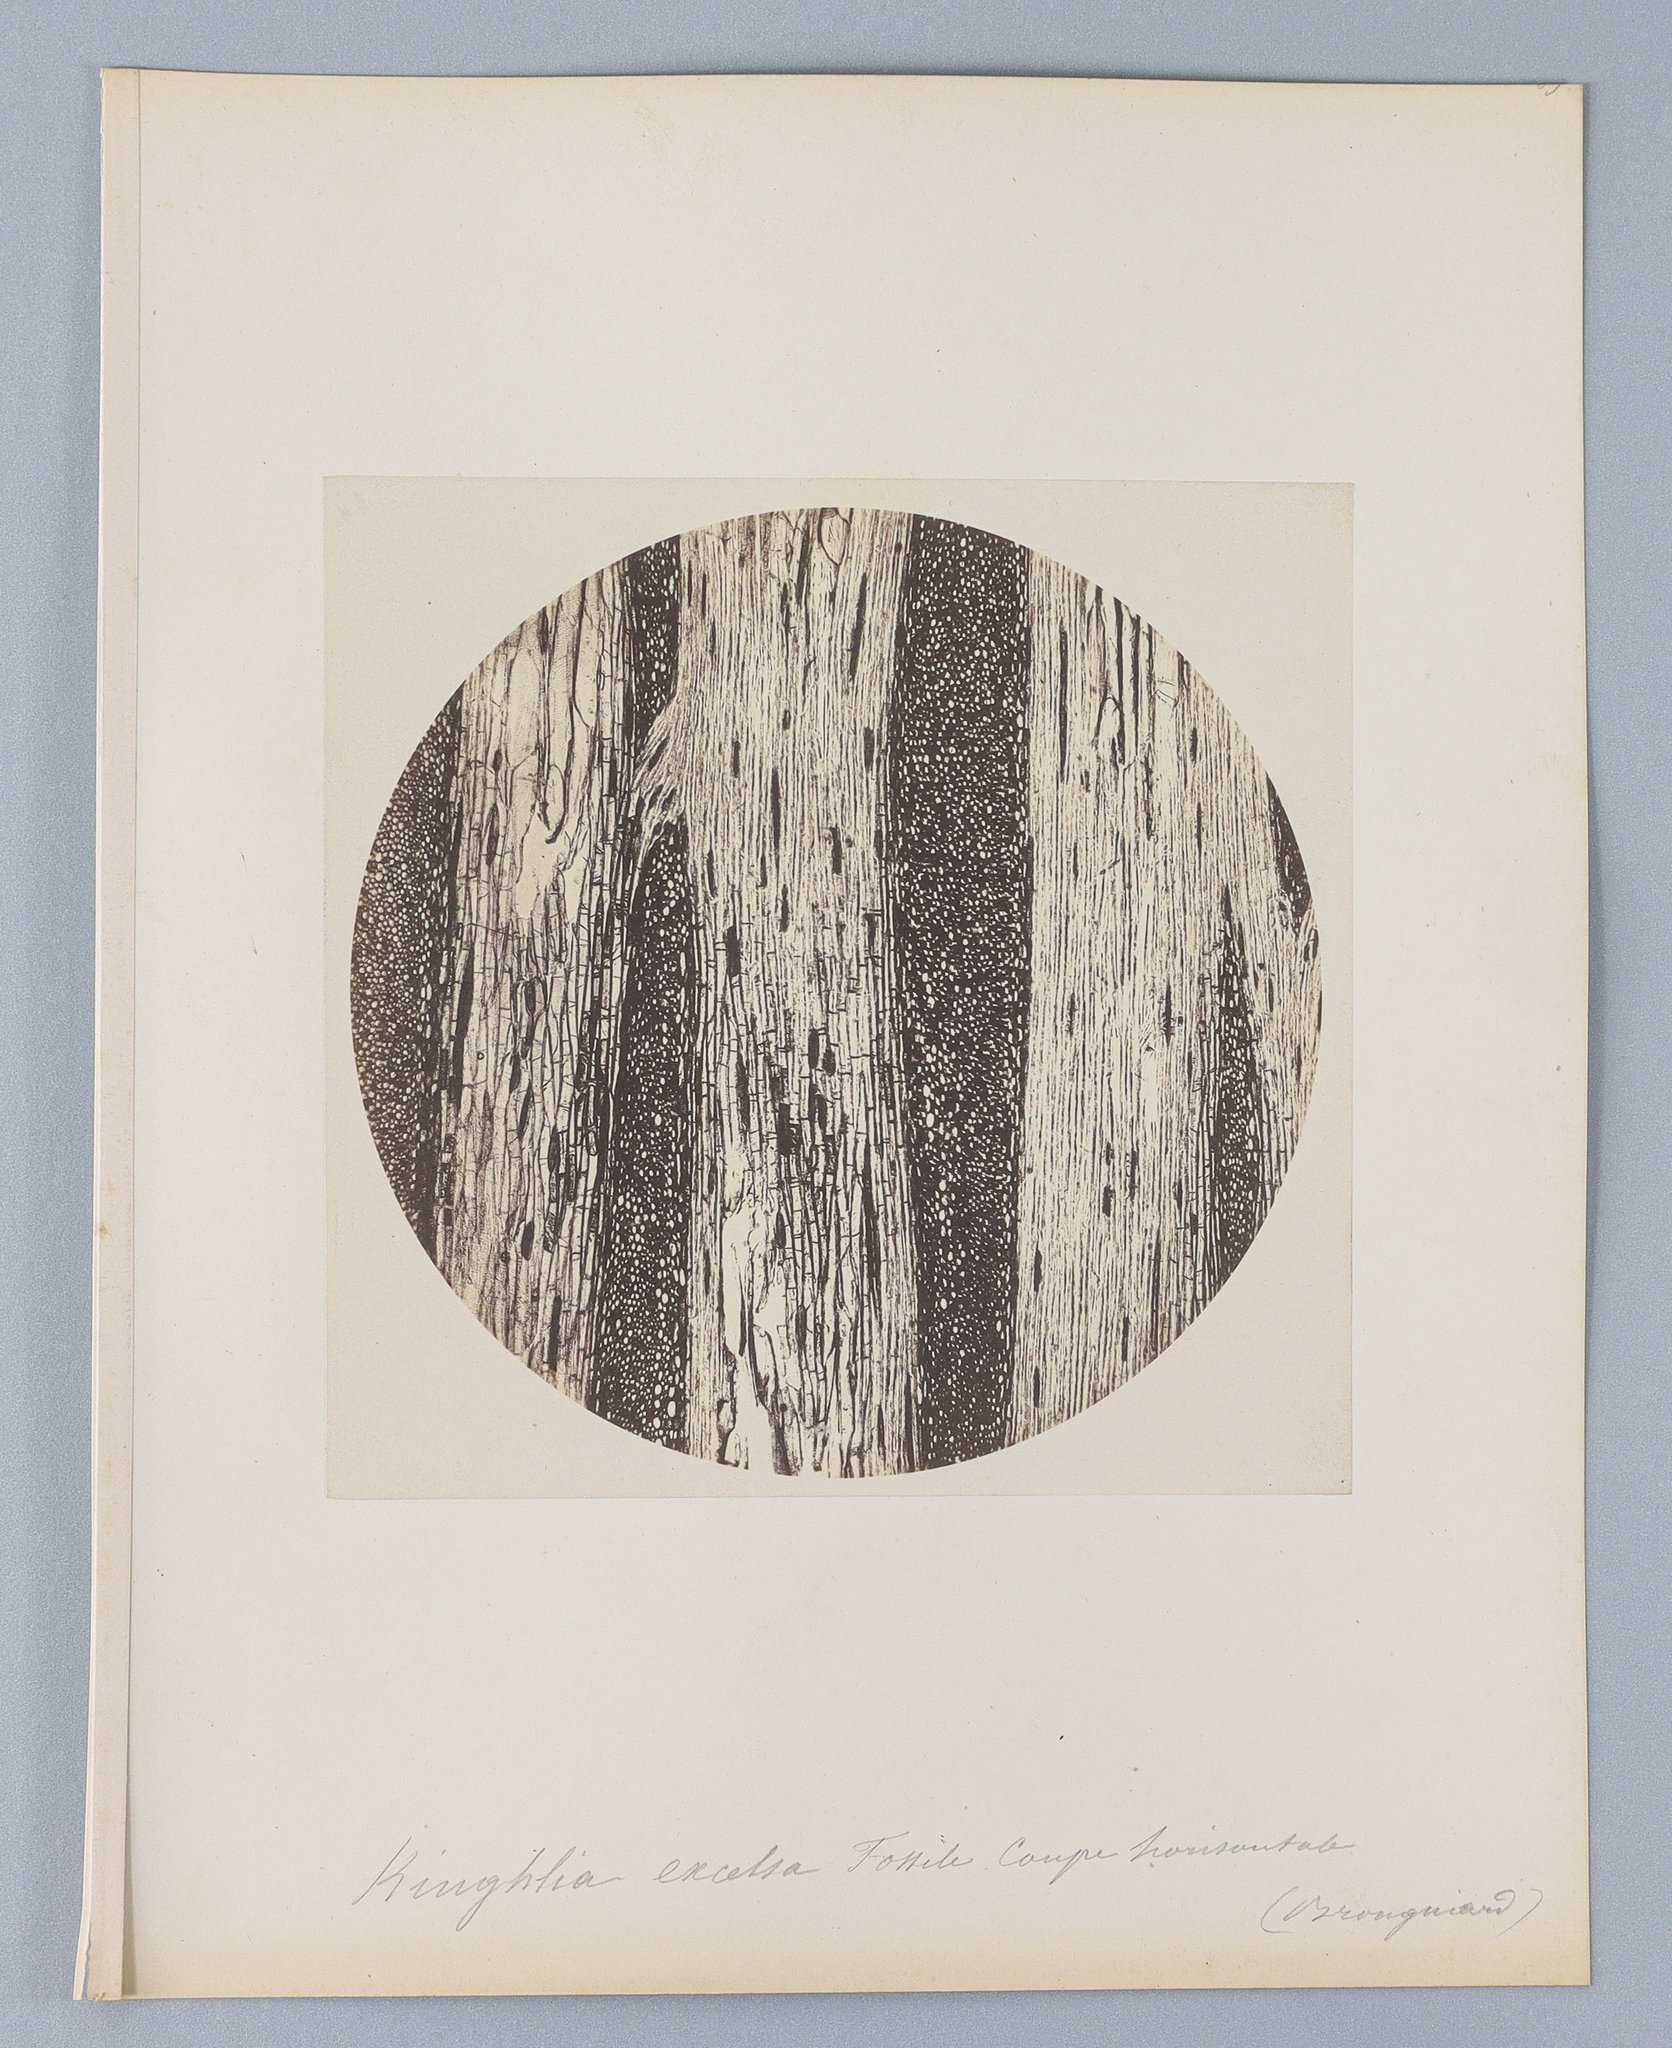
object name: photograph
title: [Untitled]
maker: auguste-adolphe bertsch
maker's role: artist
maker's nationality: french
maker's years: 1813-1871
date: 1853-1857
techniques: salted paper print